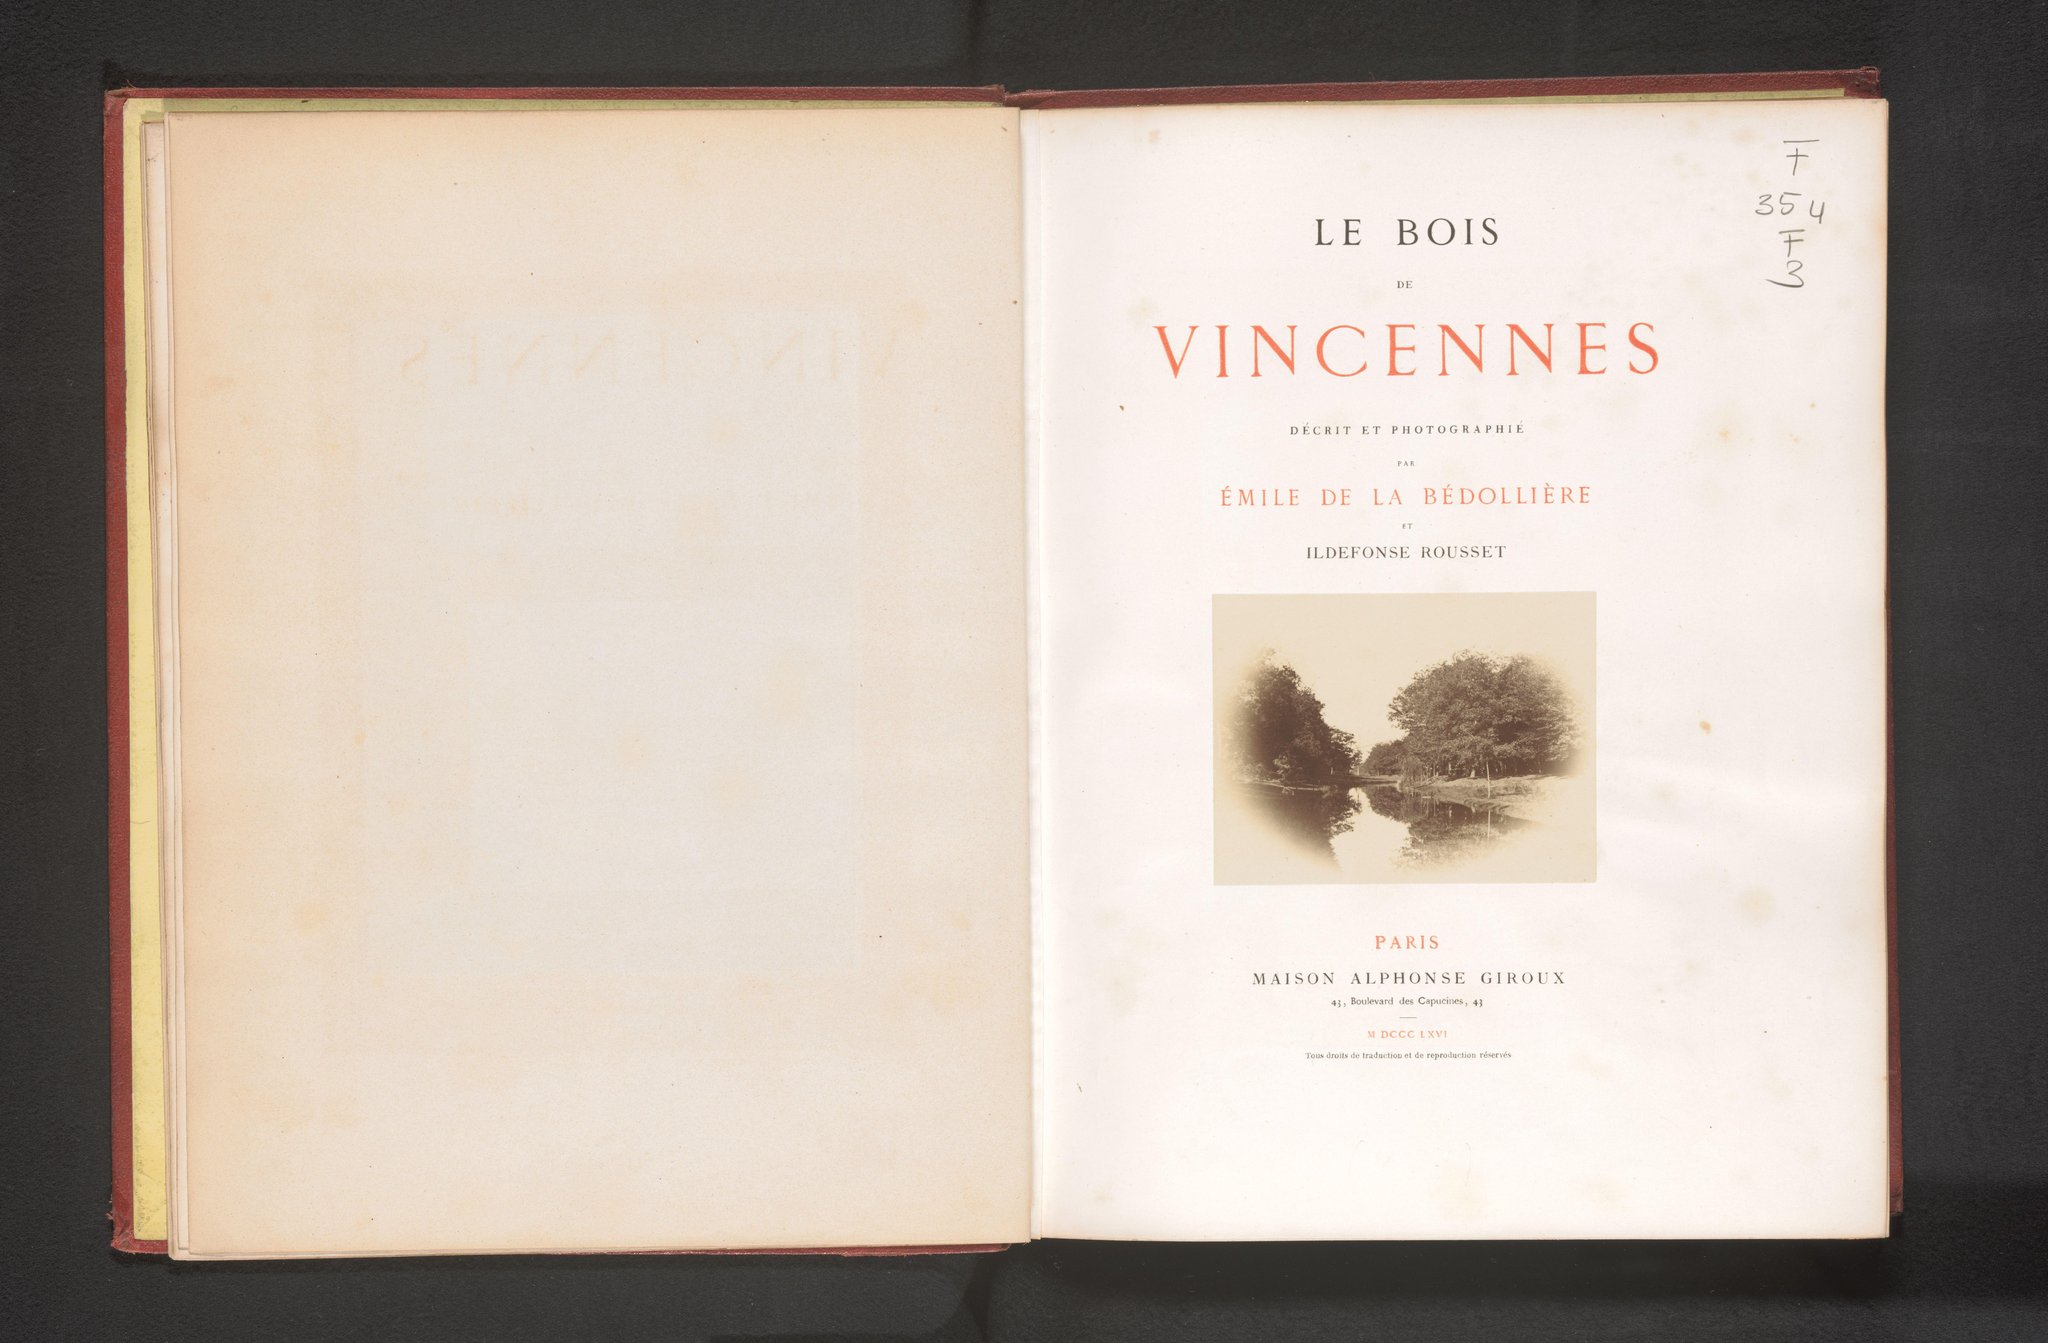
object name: page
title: Gezicht op een meer in het Bois de Vincennes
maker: émile de la bédollière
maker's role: journalist, schrijver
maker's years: 1812-1883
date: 1861-1866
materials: photographic support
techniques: albumen print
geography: bois de vincennes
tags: lake, public gardens, park